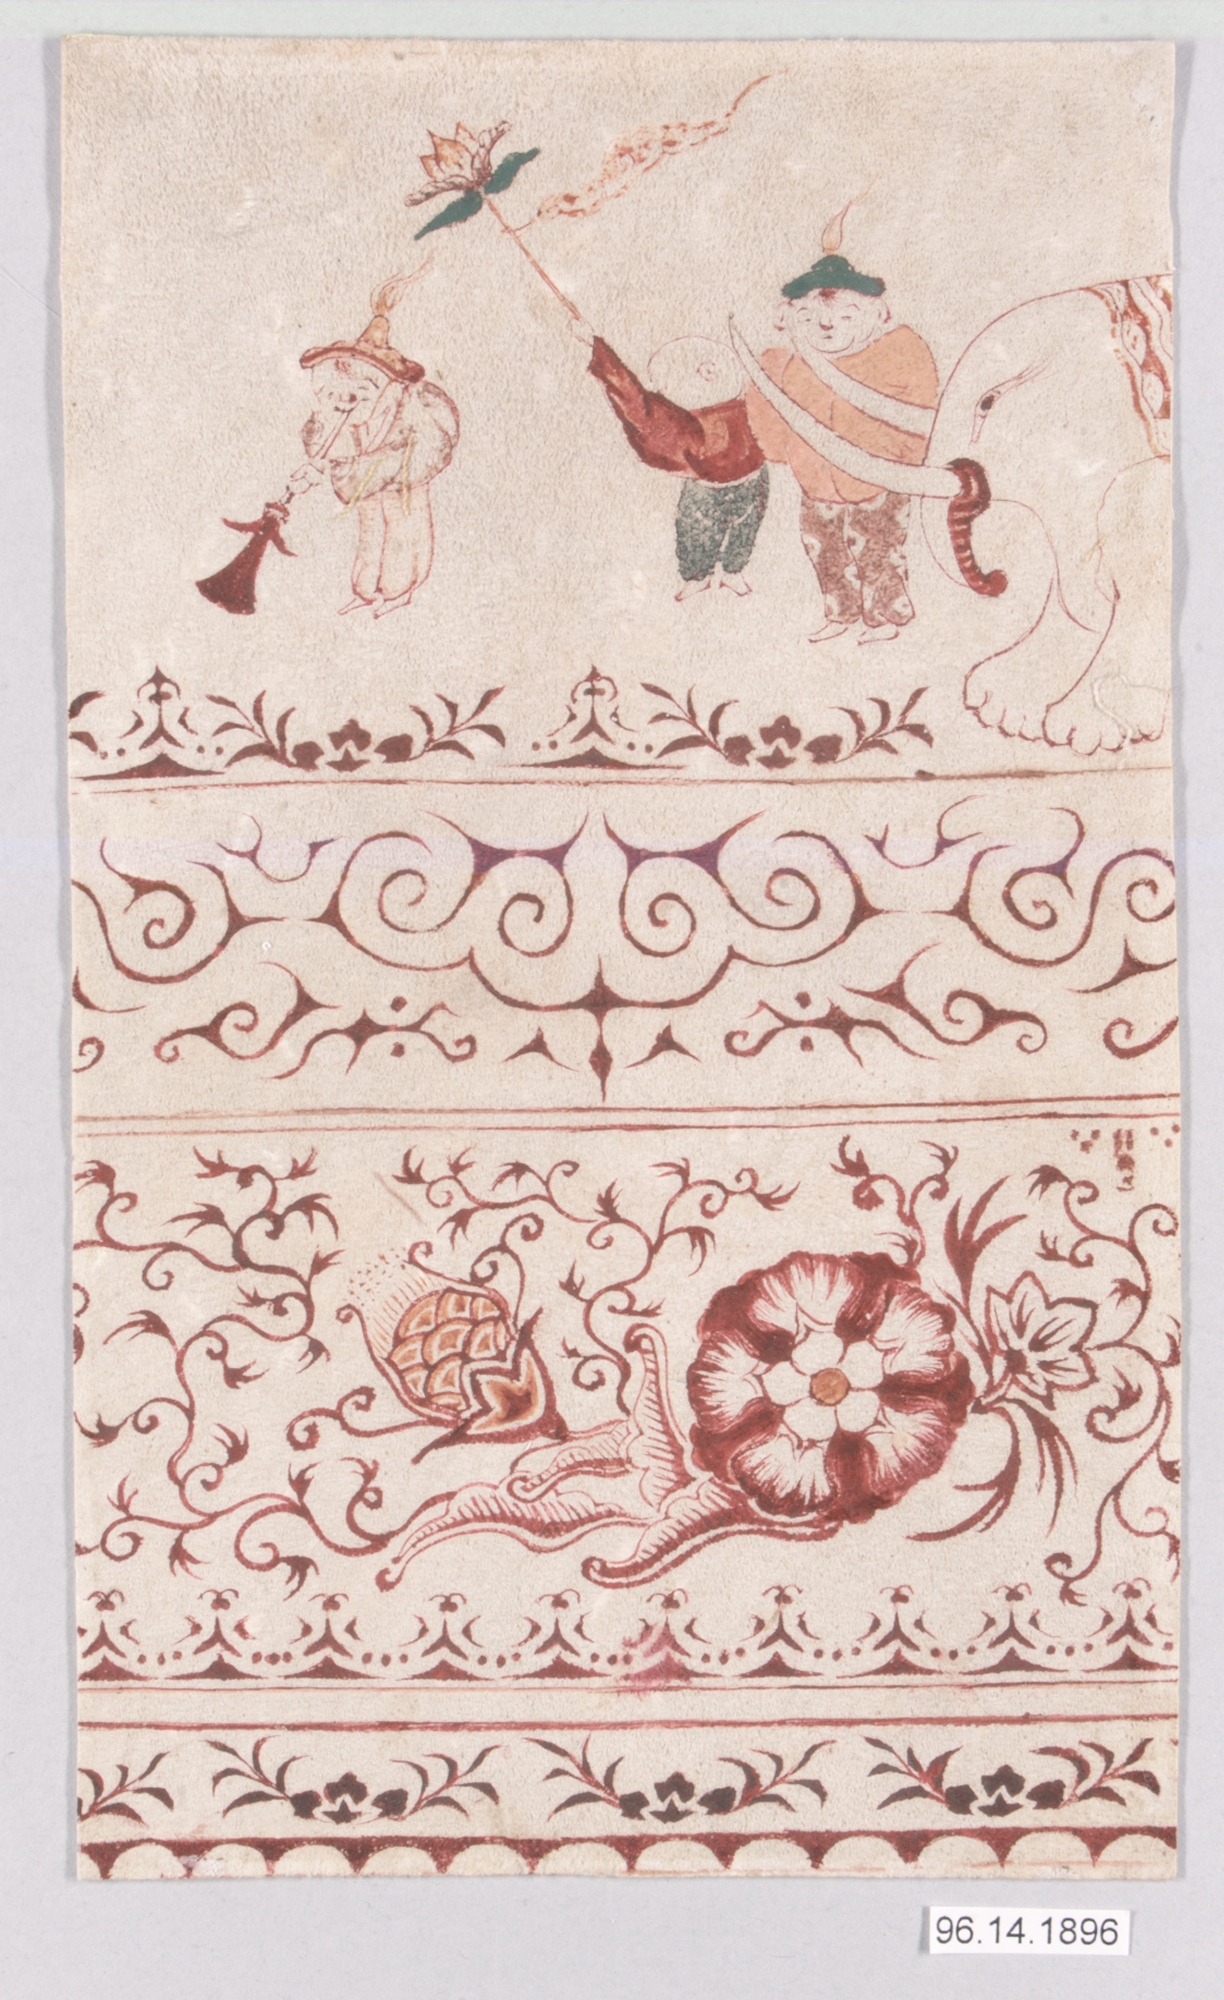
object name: panel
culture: chinese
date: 1701-1800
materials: leather, paint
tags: musical instruments,men,elephants,flowers